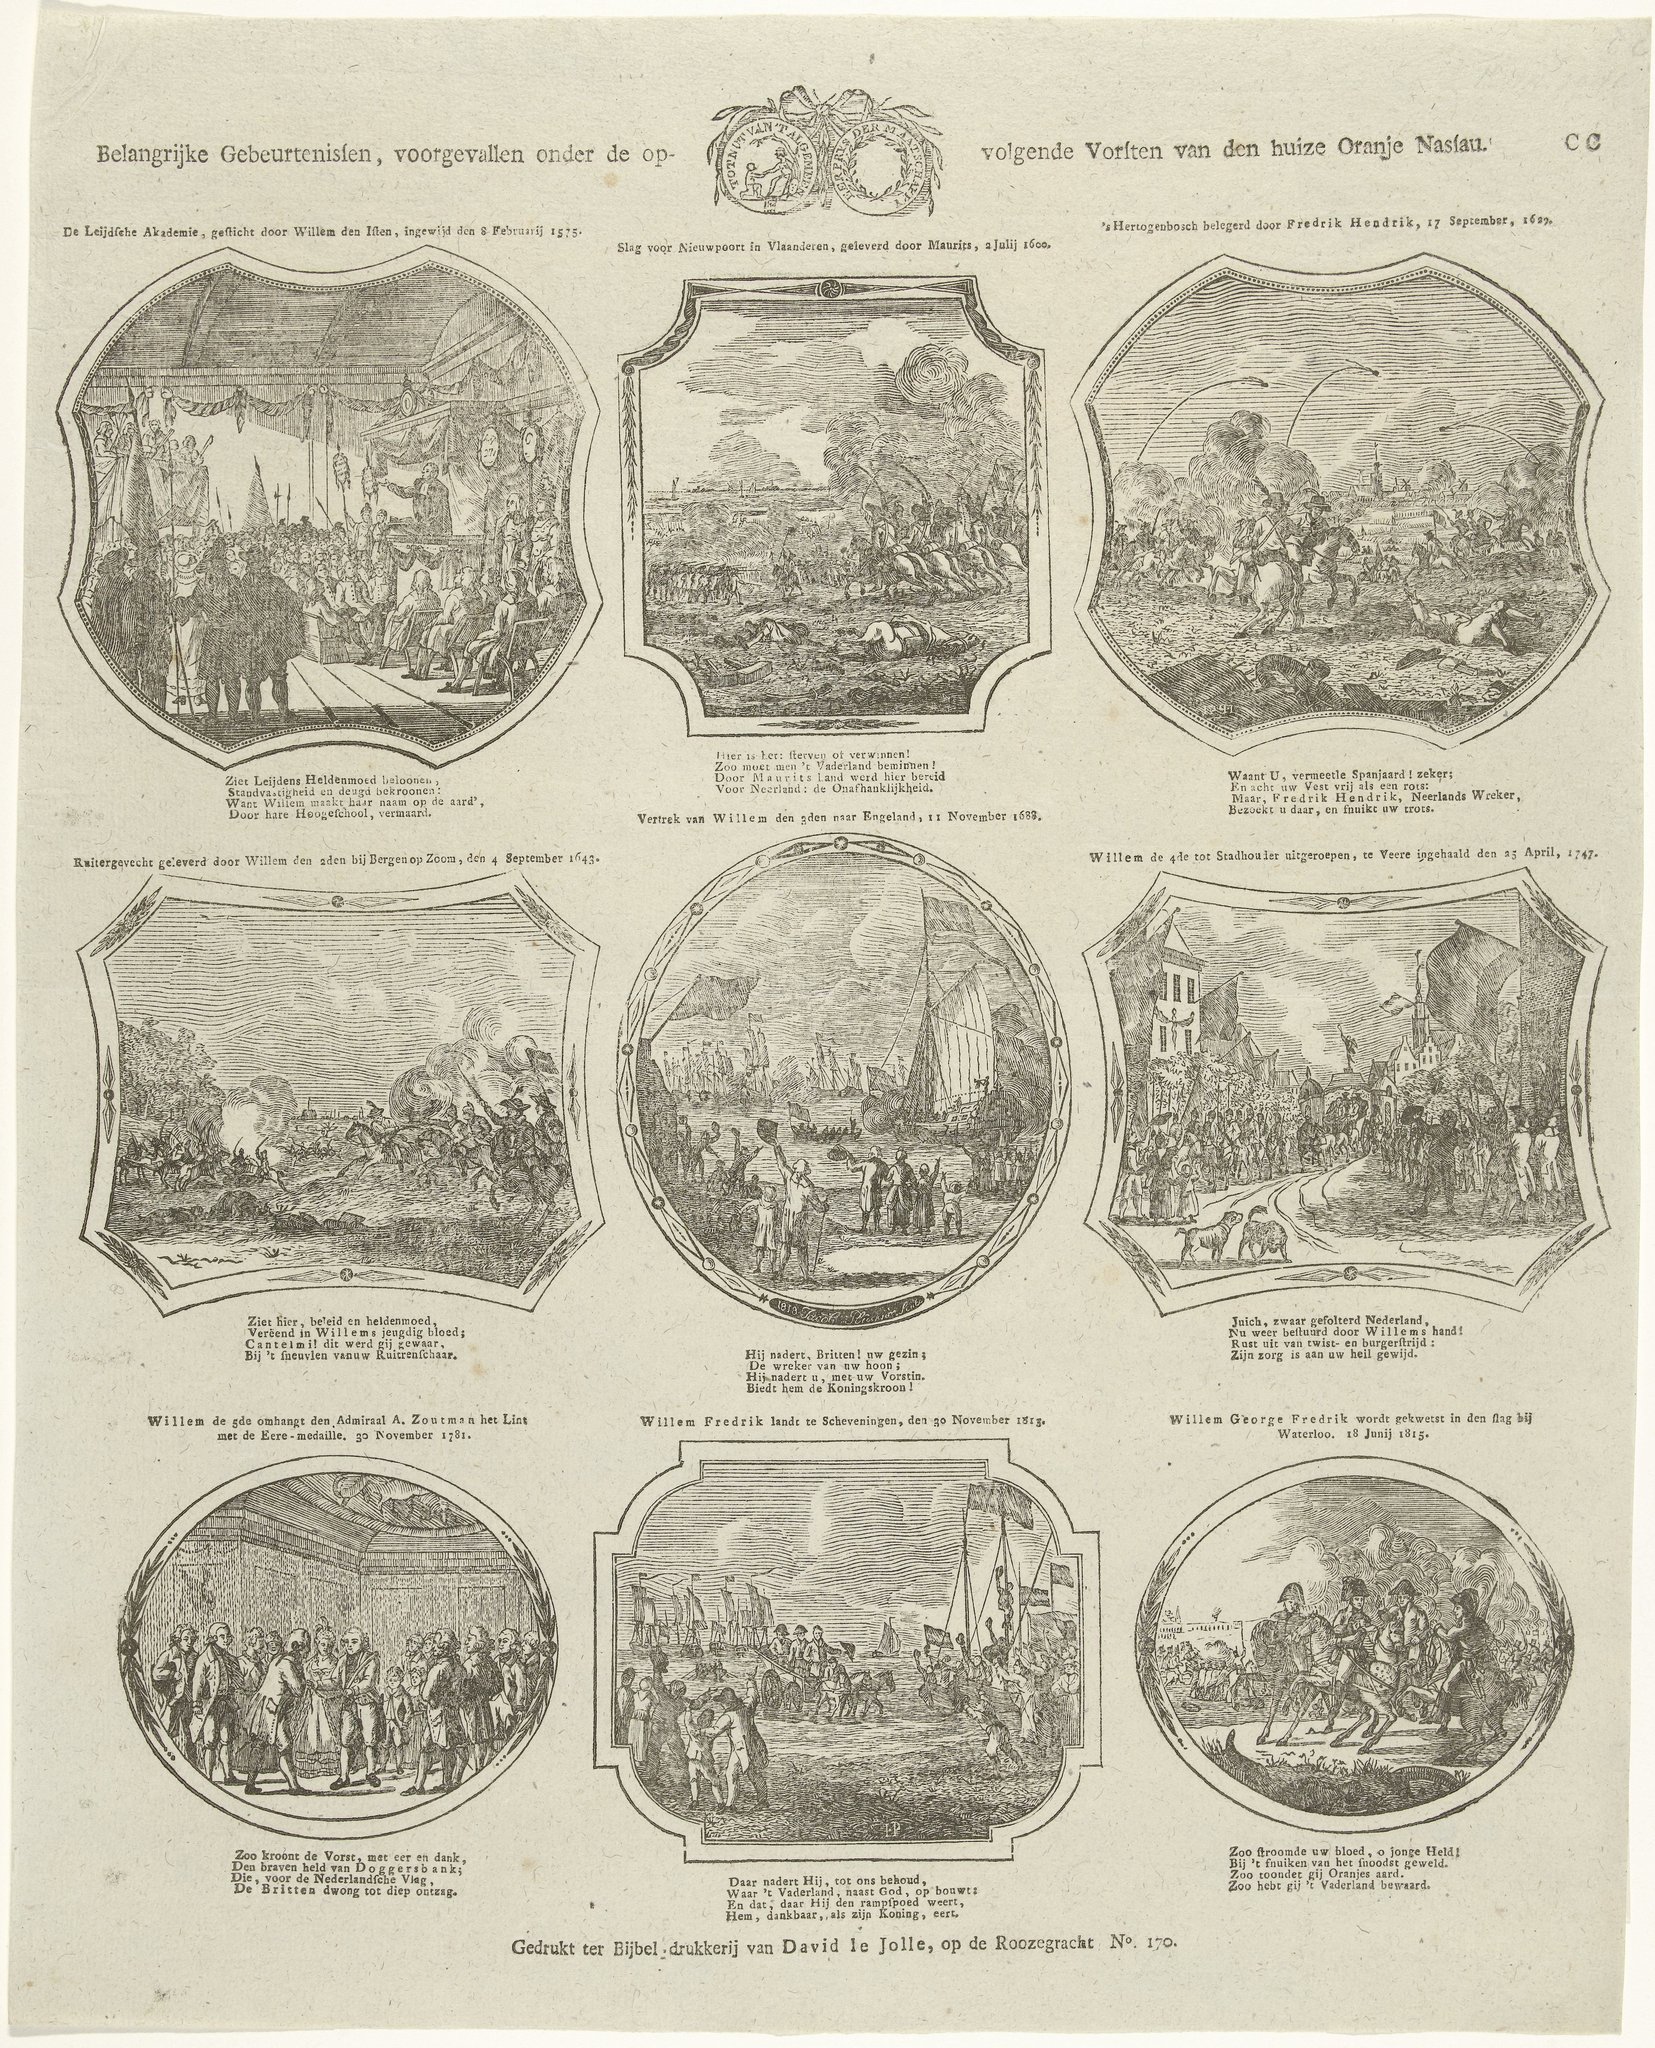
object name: print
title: Belangrijke gebeurtenissen, voorgevallen onder de op- / volgende vorsten van den huize Oranje Nassau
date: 1814-1820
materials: paper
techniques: letterpress printing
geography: netherlands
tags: battle (+ land forces)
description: Blad met 9 voorstellingen van historische gebeurtenissen onder vorsten uit het huis Oranje Nassau, van prins Willem I in 1575 tot Willem Frederik George Lodewijk bij de slag bij Waterloo in 1815. Midden boven het zegel van de Maatschappij tot Nut van 't Algemeen. Boven elke afbeelding een titel met datum, onder elke afbeelding een vierregelig vers. Genummerd rechtsboven: CC.